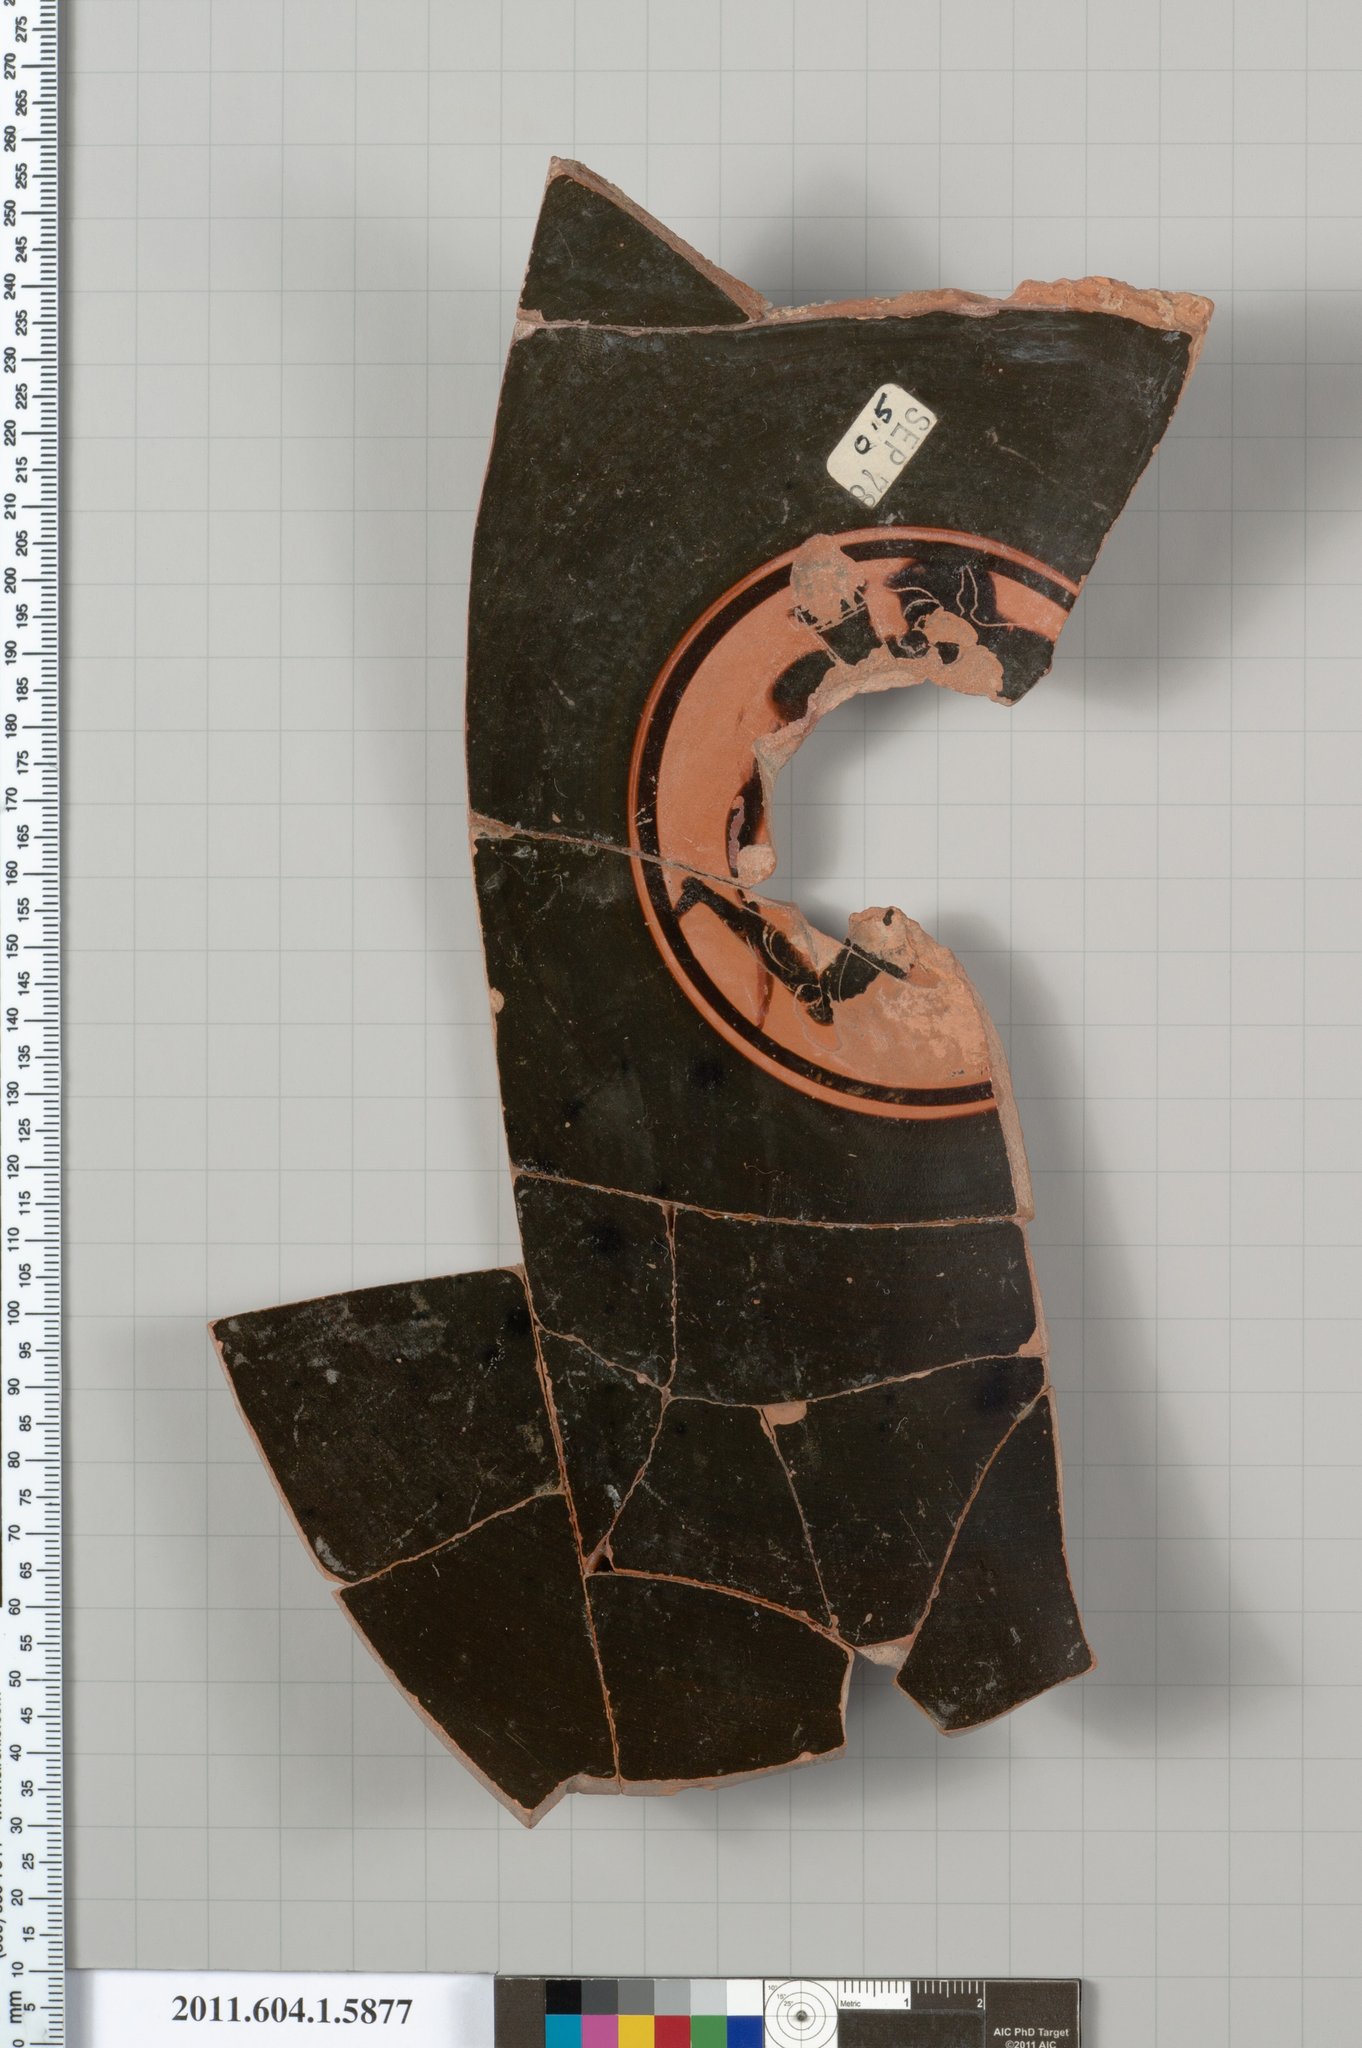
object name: kylix fragment, eye cup, bilingual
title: Terracotta fragment of a kylix (drinking cup)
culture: greek, attic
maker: oltos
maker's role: artist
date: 433-567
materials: terracotta